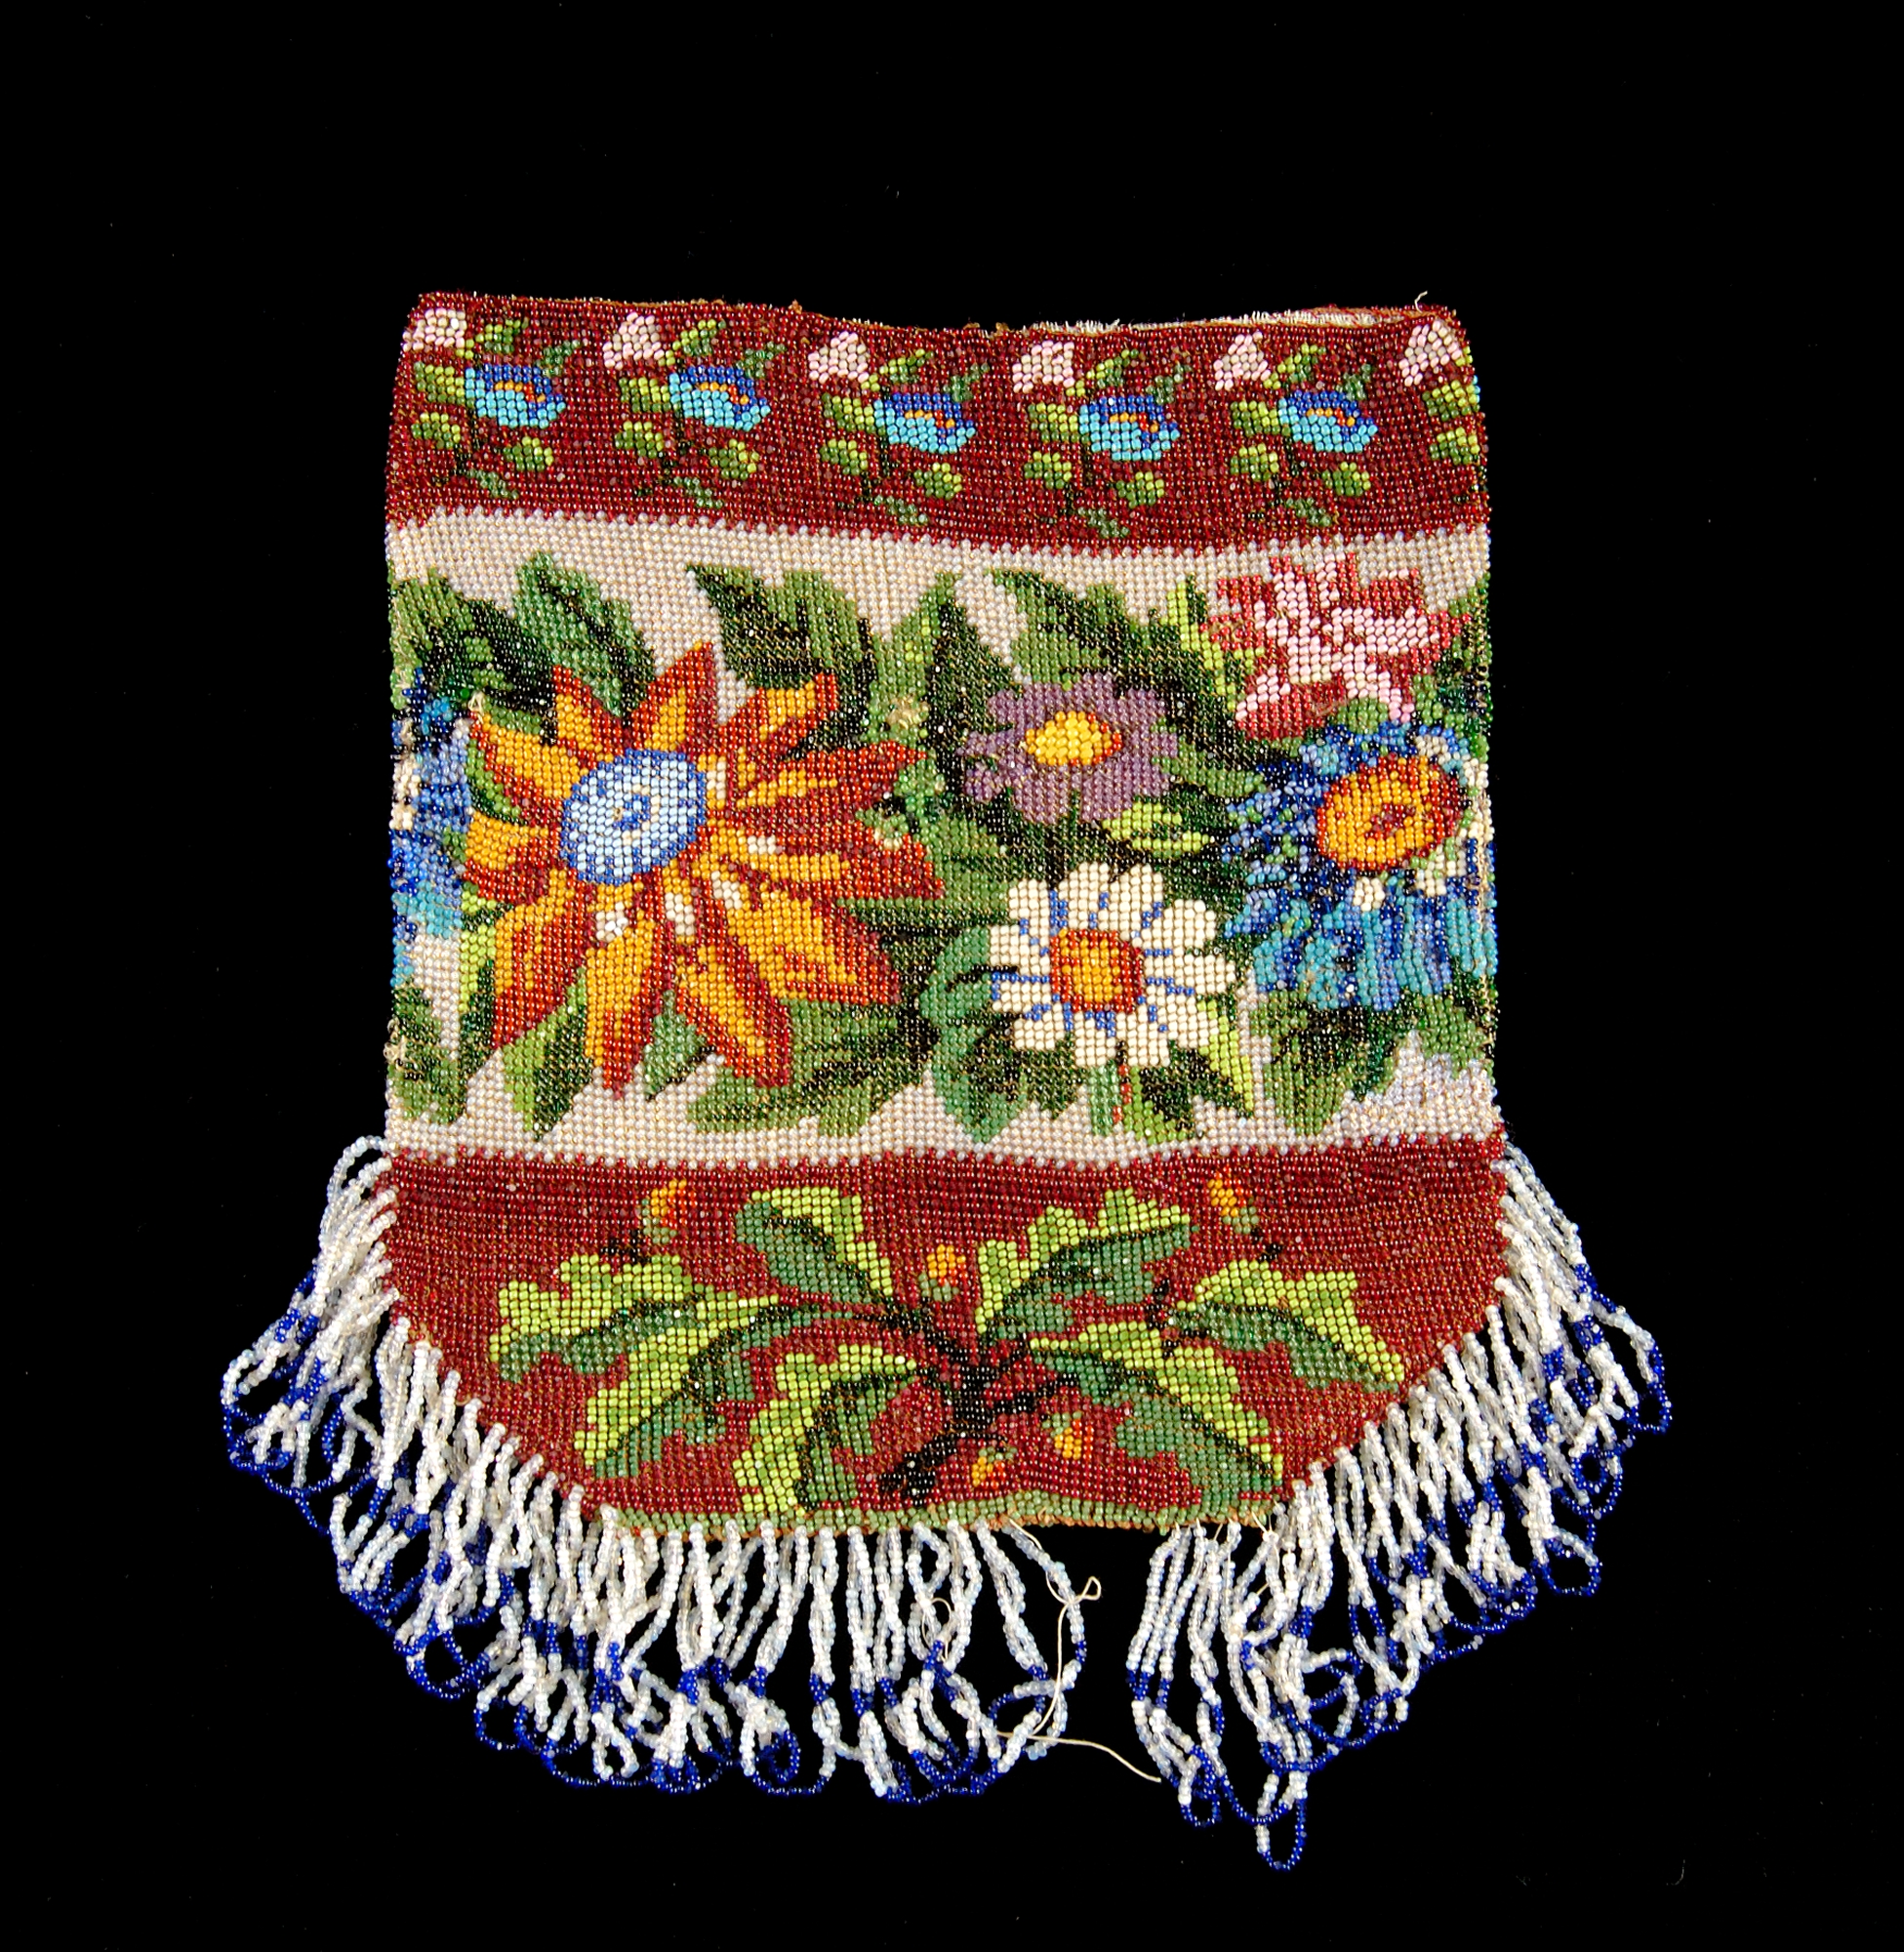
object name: pouch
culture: american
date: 1830-1860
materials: glass, linen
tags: flowers